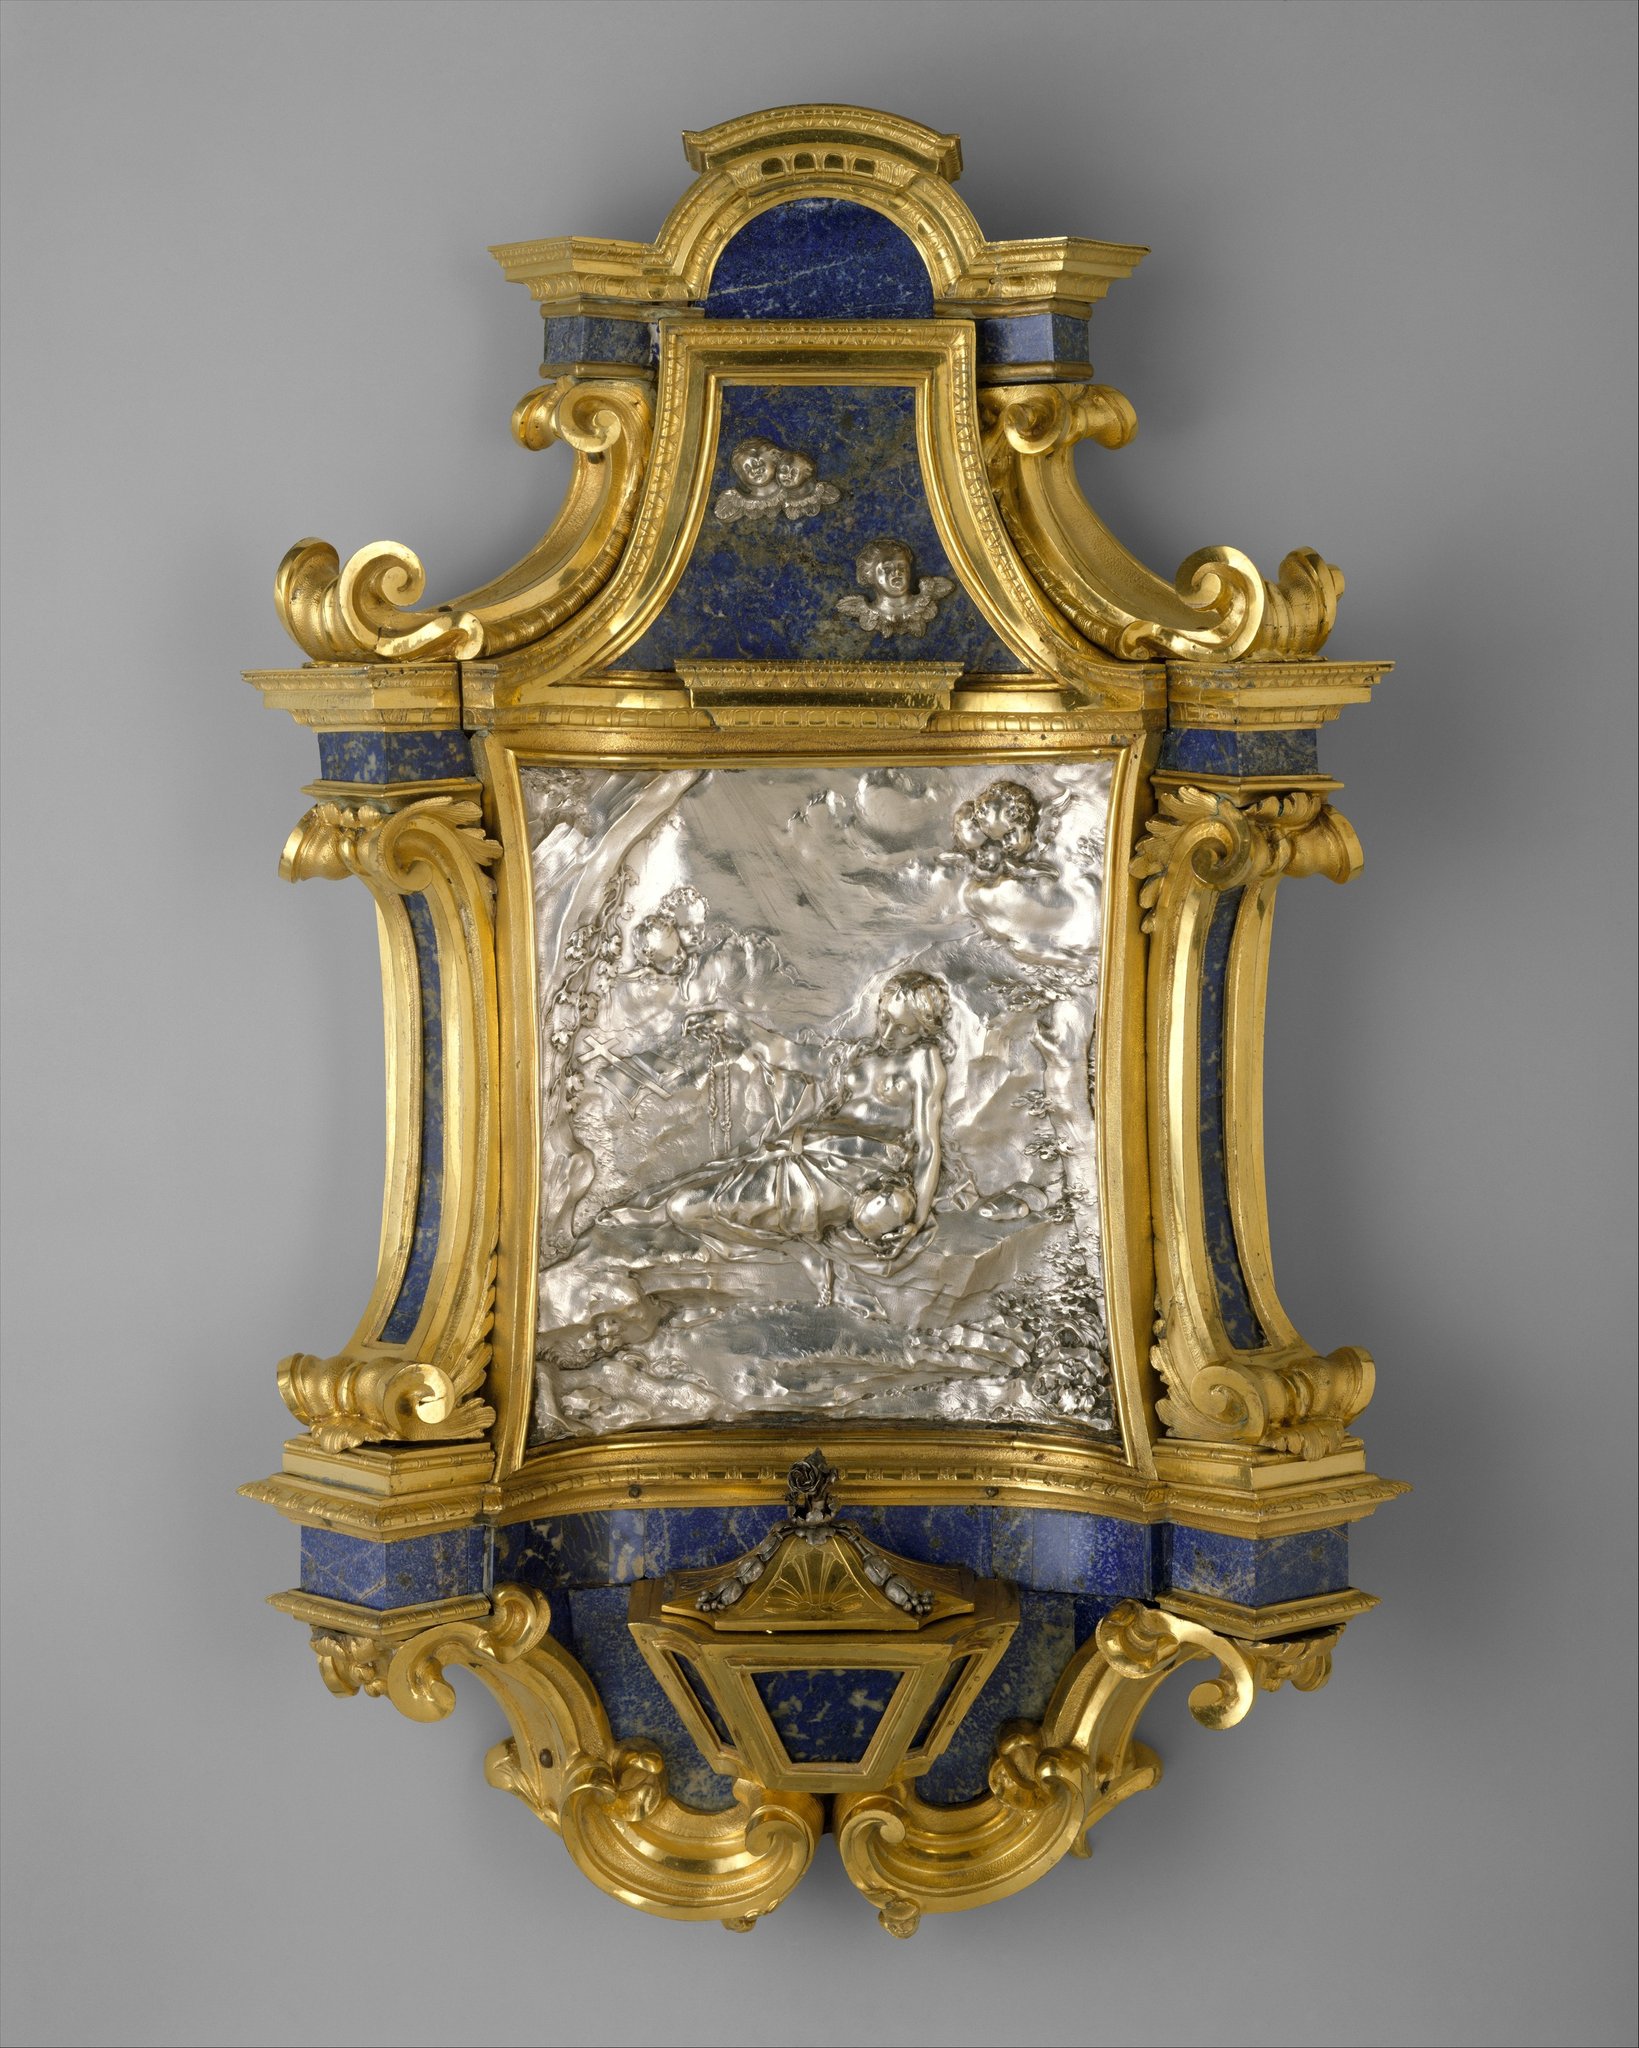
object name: holy water stoup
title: Holy-water stoup with relief of Mary of Egypt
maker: giovanni giardini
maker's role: maker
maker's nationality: italian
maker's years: 1646-1722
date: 1702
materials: bronze, lapis lazuli, silver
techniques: gilding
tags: female nudes,saints